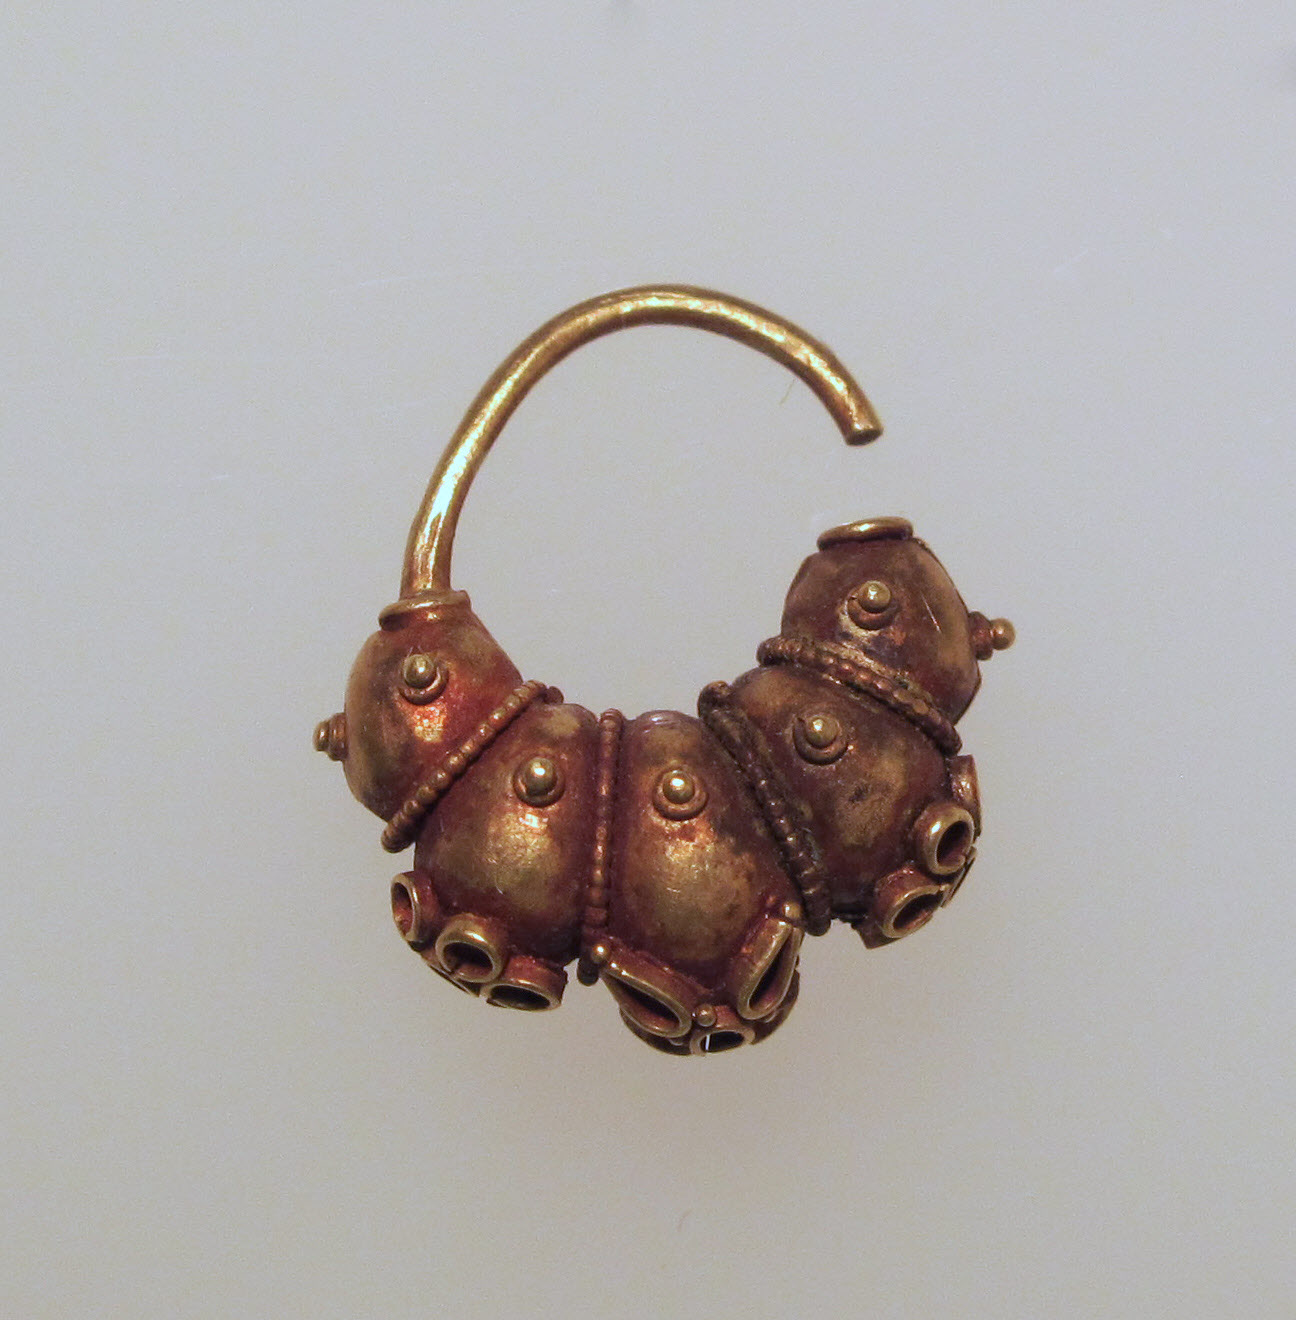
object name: earring with lobe and rosette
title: Electrum earring with lobes and rosettes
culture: cypriot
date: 600-501 BCE